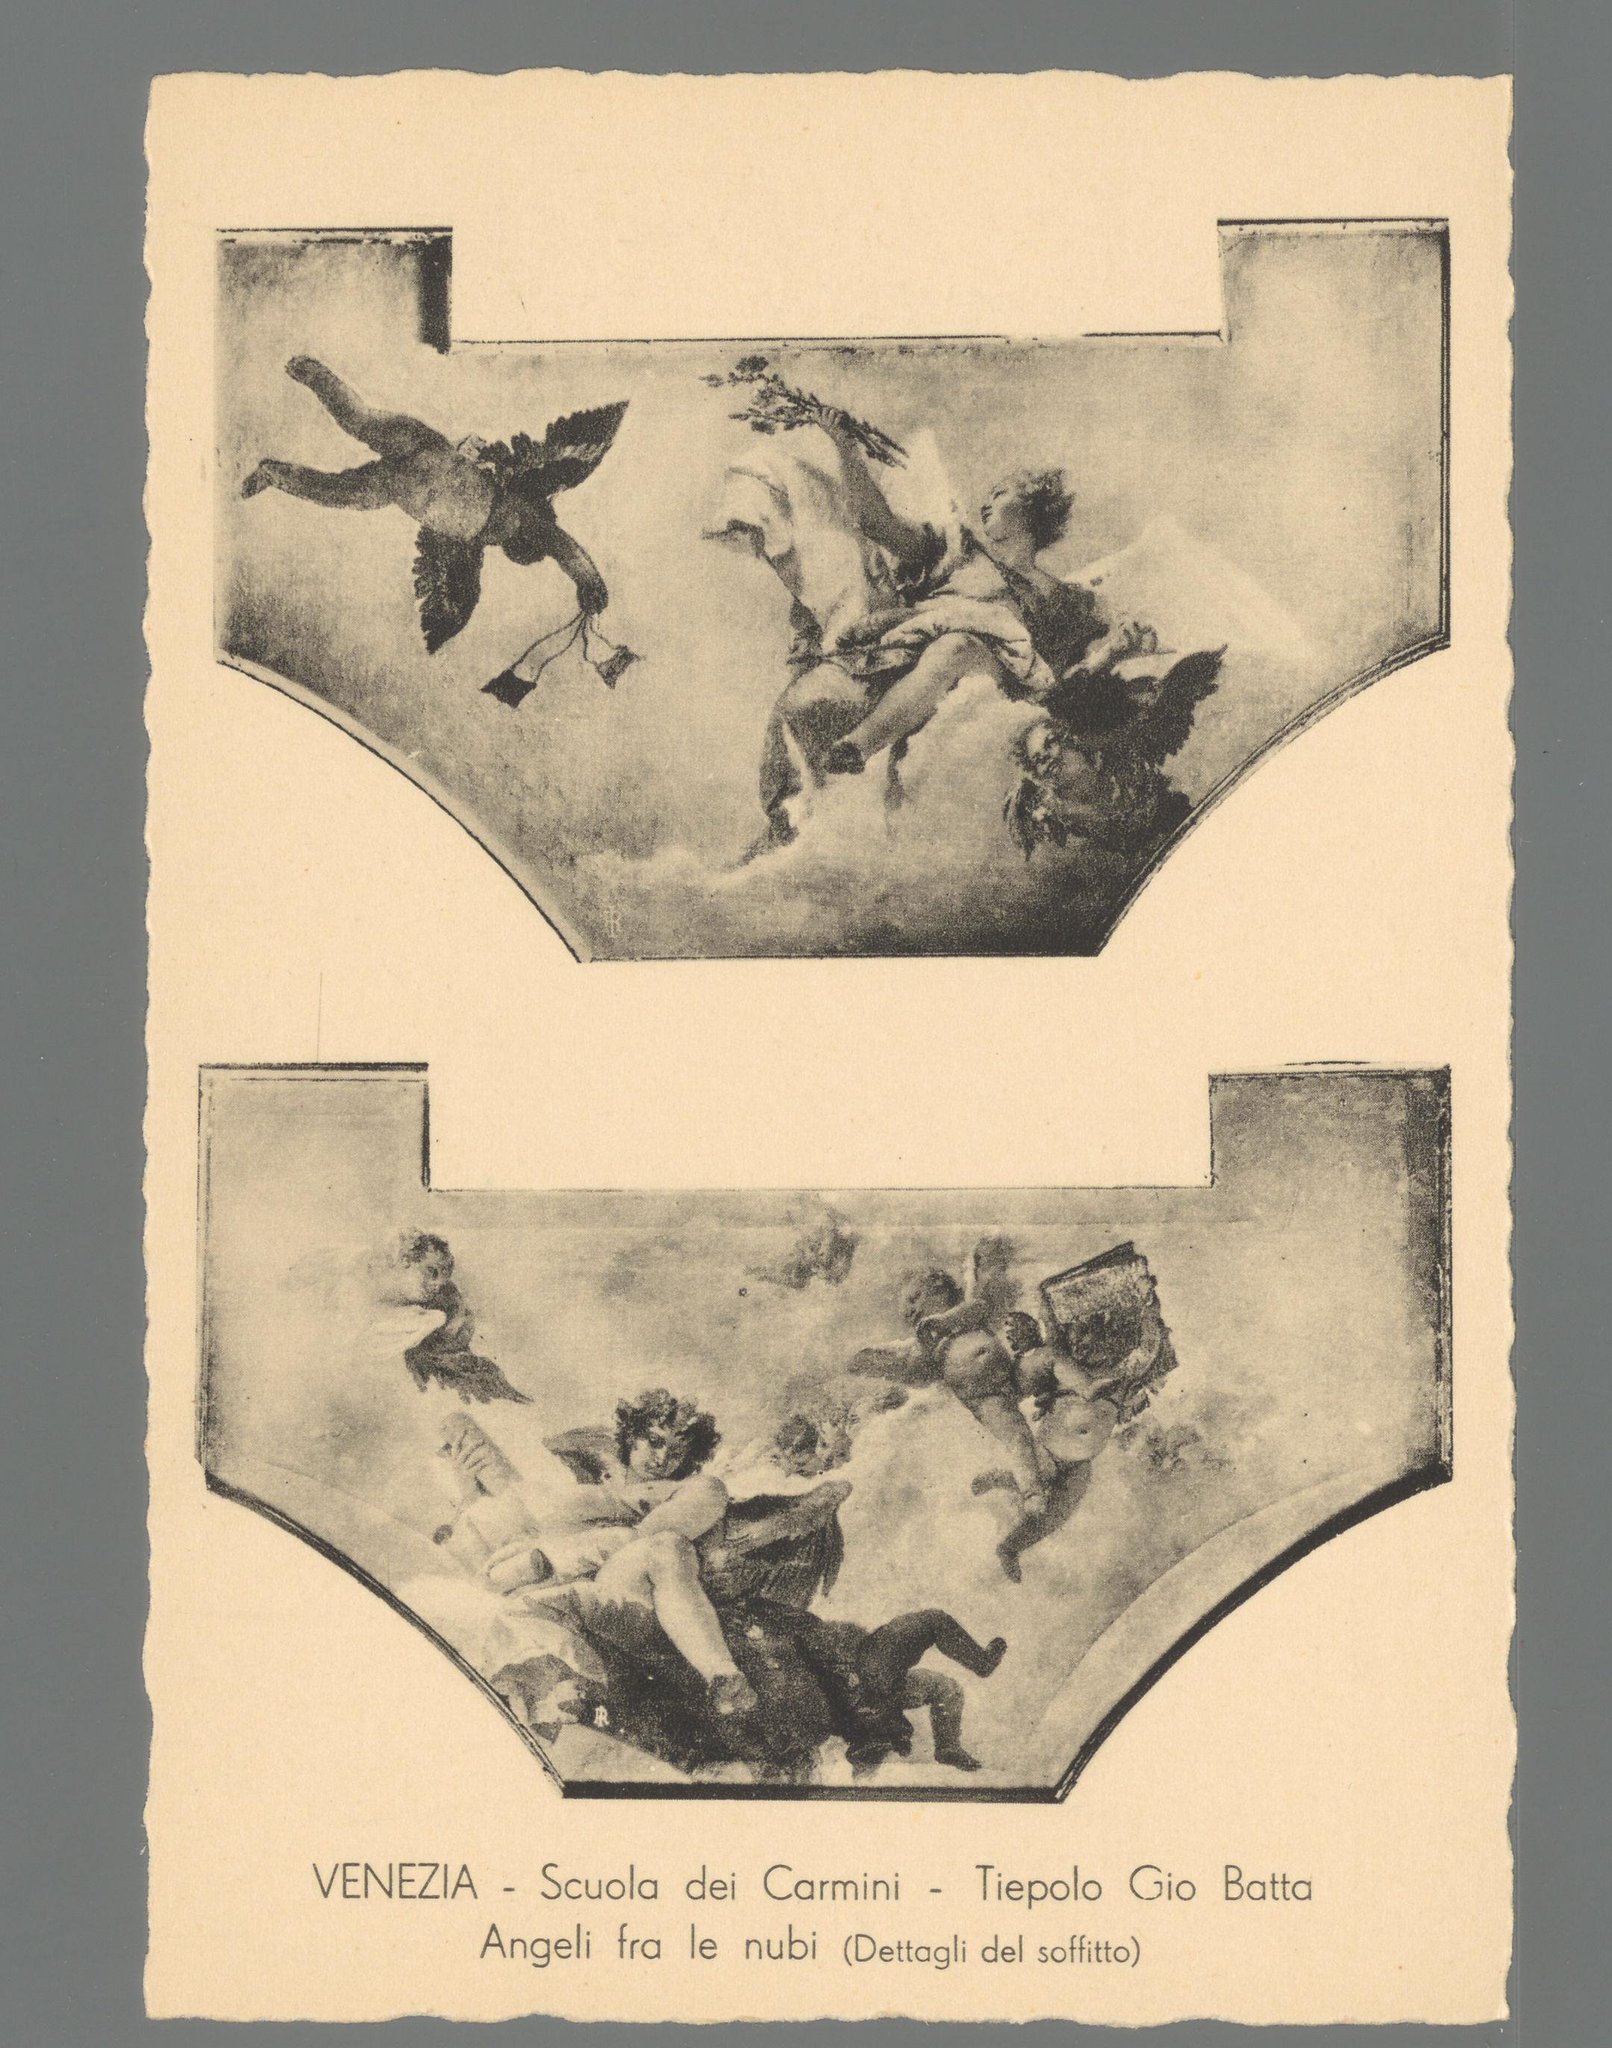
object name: photomechanical print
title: Venezia. Scuola dei Carmini. Tiepolo Gio Batta. Angeli fra le nubi (Detaggli del soffitto)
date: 1906-1930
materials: cardboard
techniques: photograph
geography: chiavari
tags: (decorated) ceiling, angels